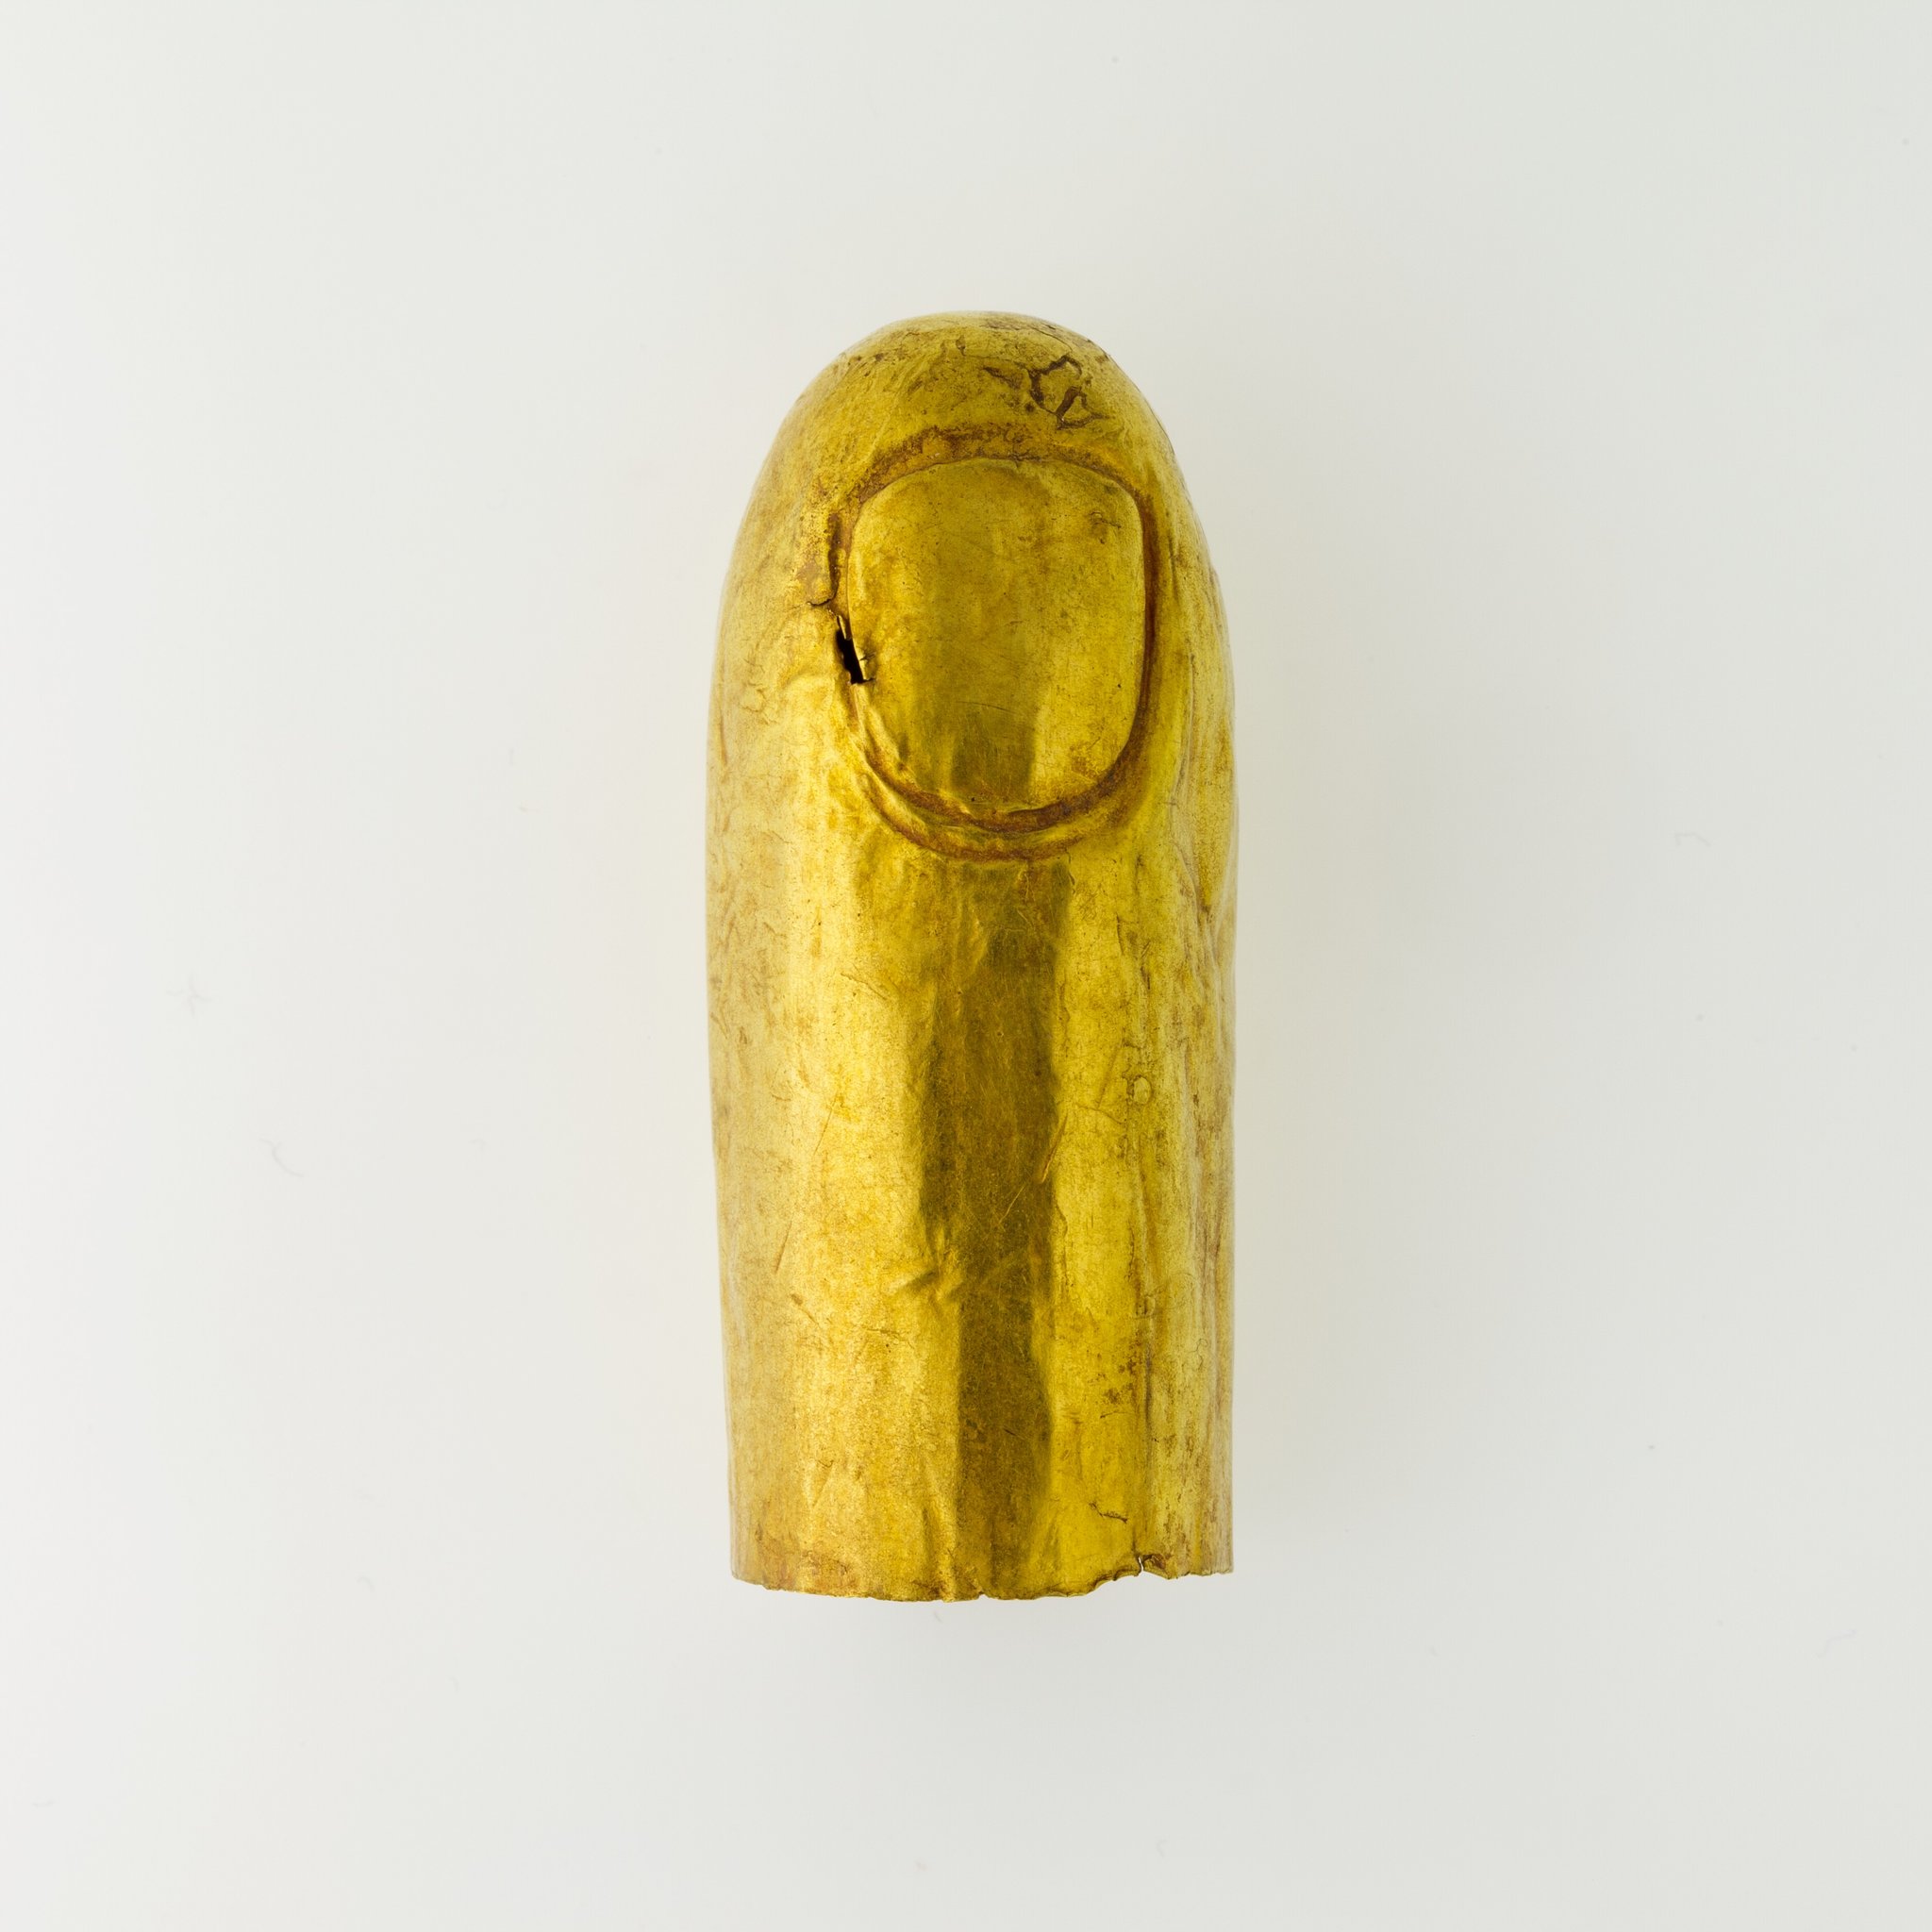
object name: toe stall, group 1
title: Toe stall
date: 1479-1425 BCE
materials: gold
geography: egypt